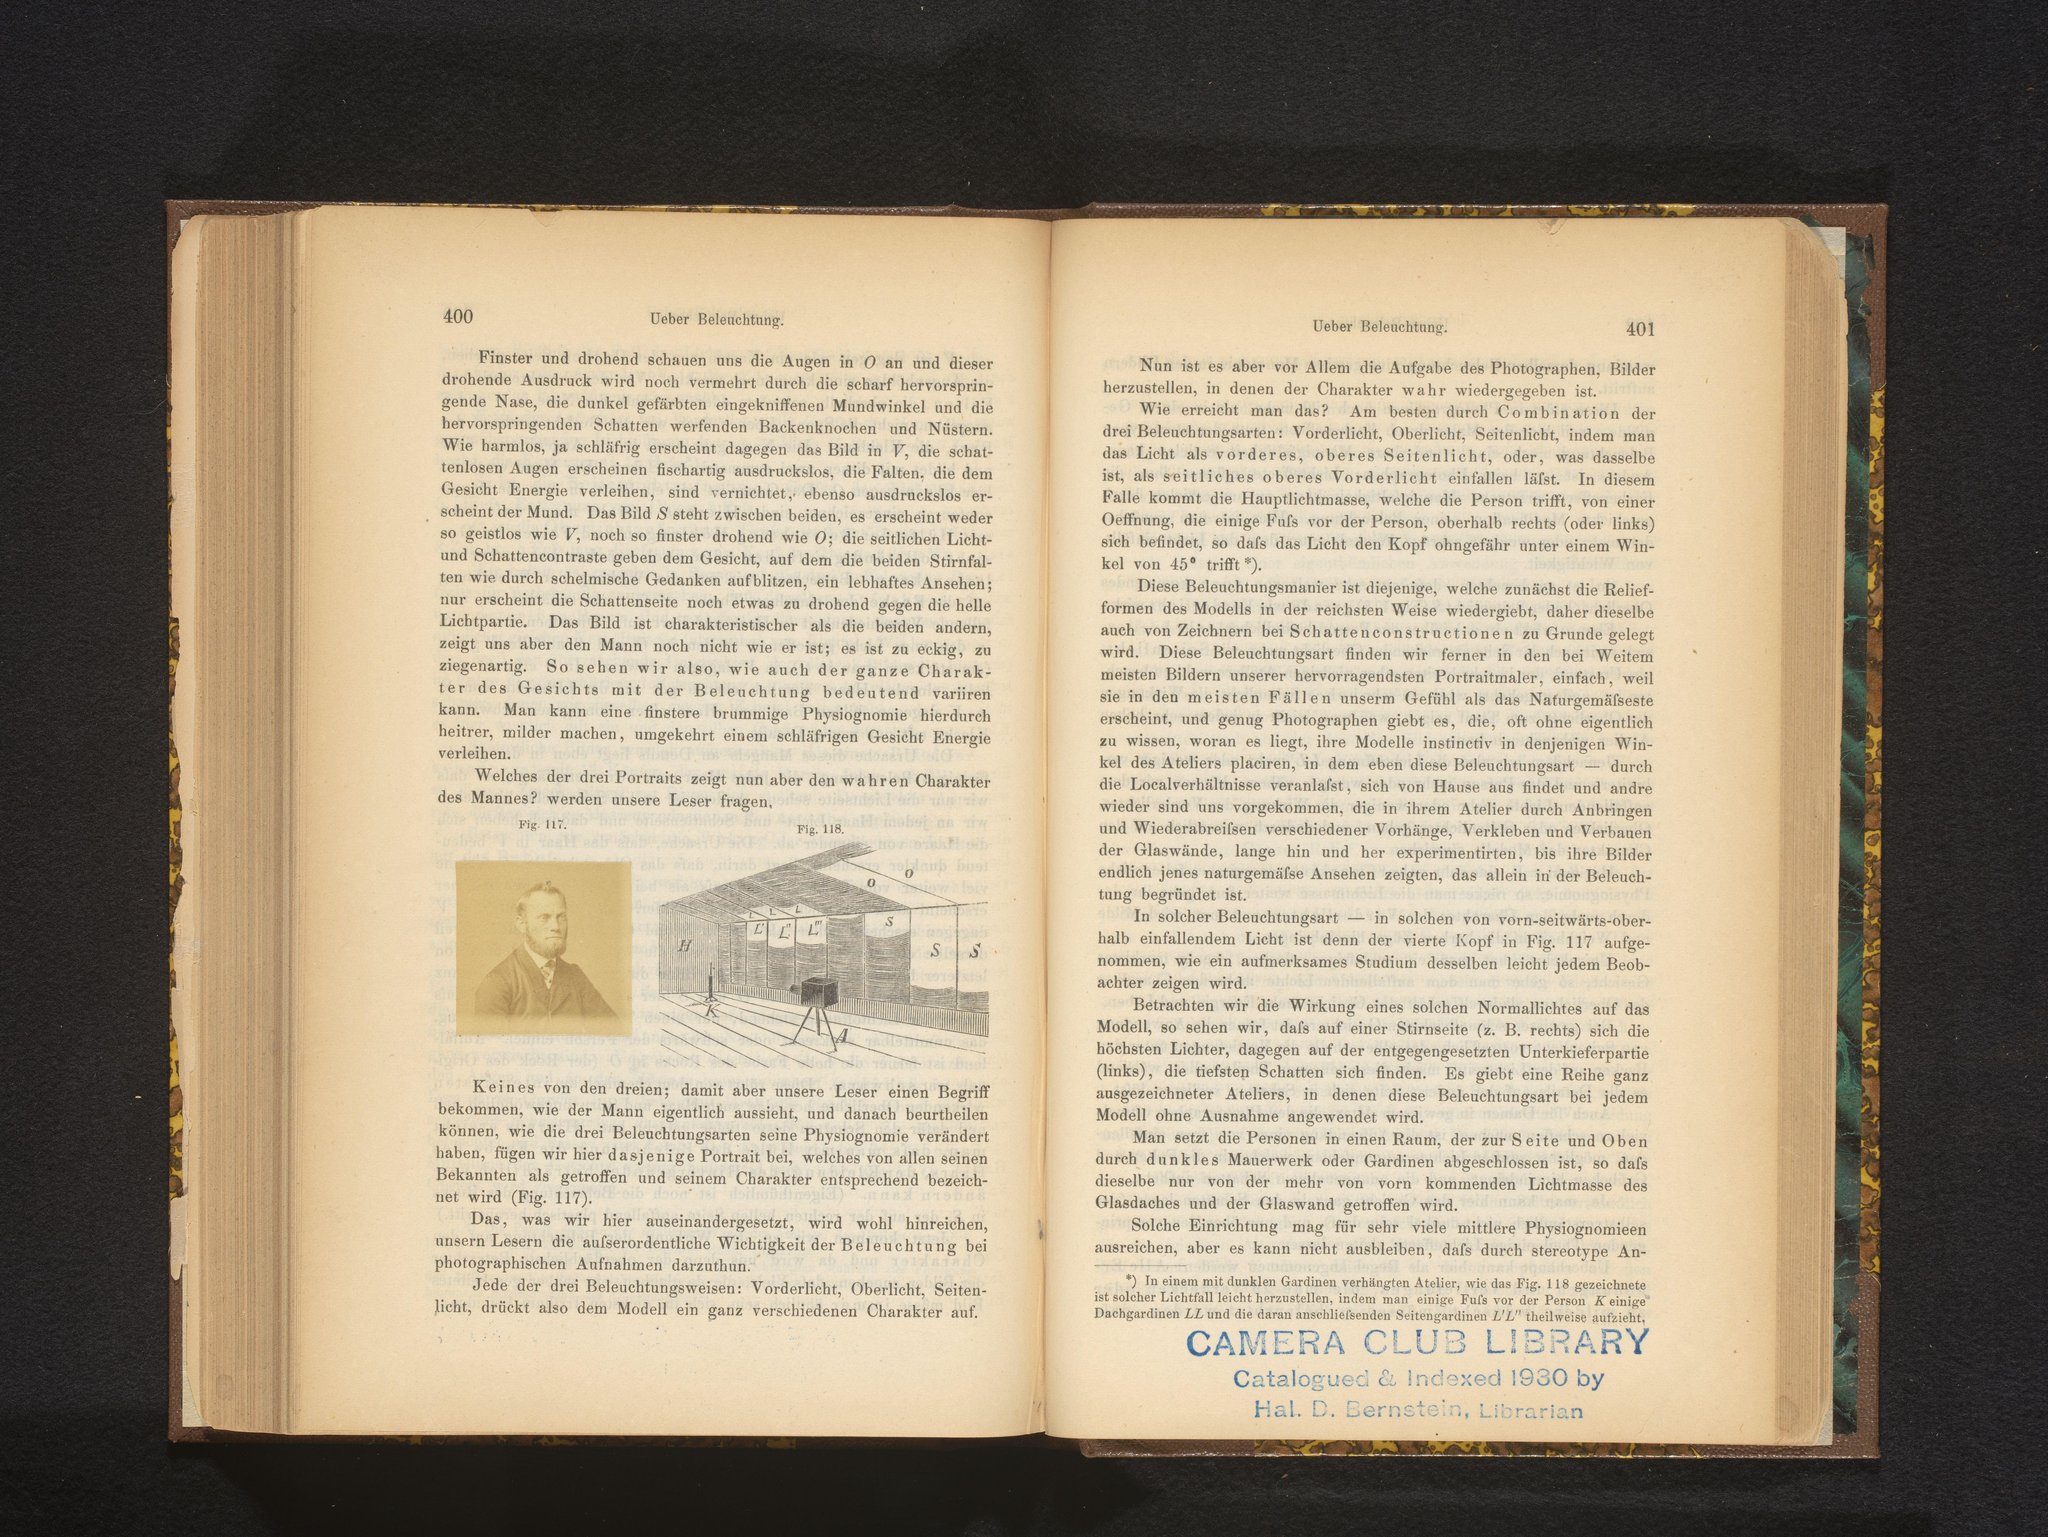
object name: page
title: Portret van een onbekende man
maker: hermann wilhelm vogel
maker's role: chemicus, fotograaf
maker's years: 1834-1898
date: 1860-1870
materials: photographic support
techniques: albumen print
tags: adult man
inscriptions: number: ‘Fig. 117.’